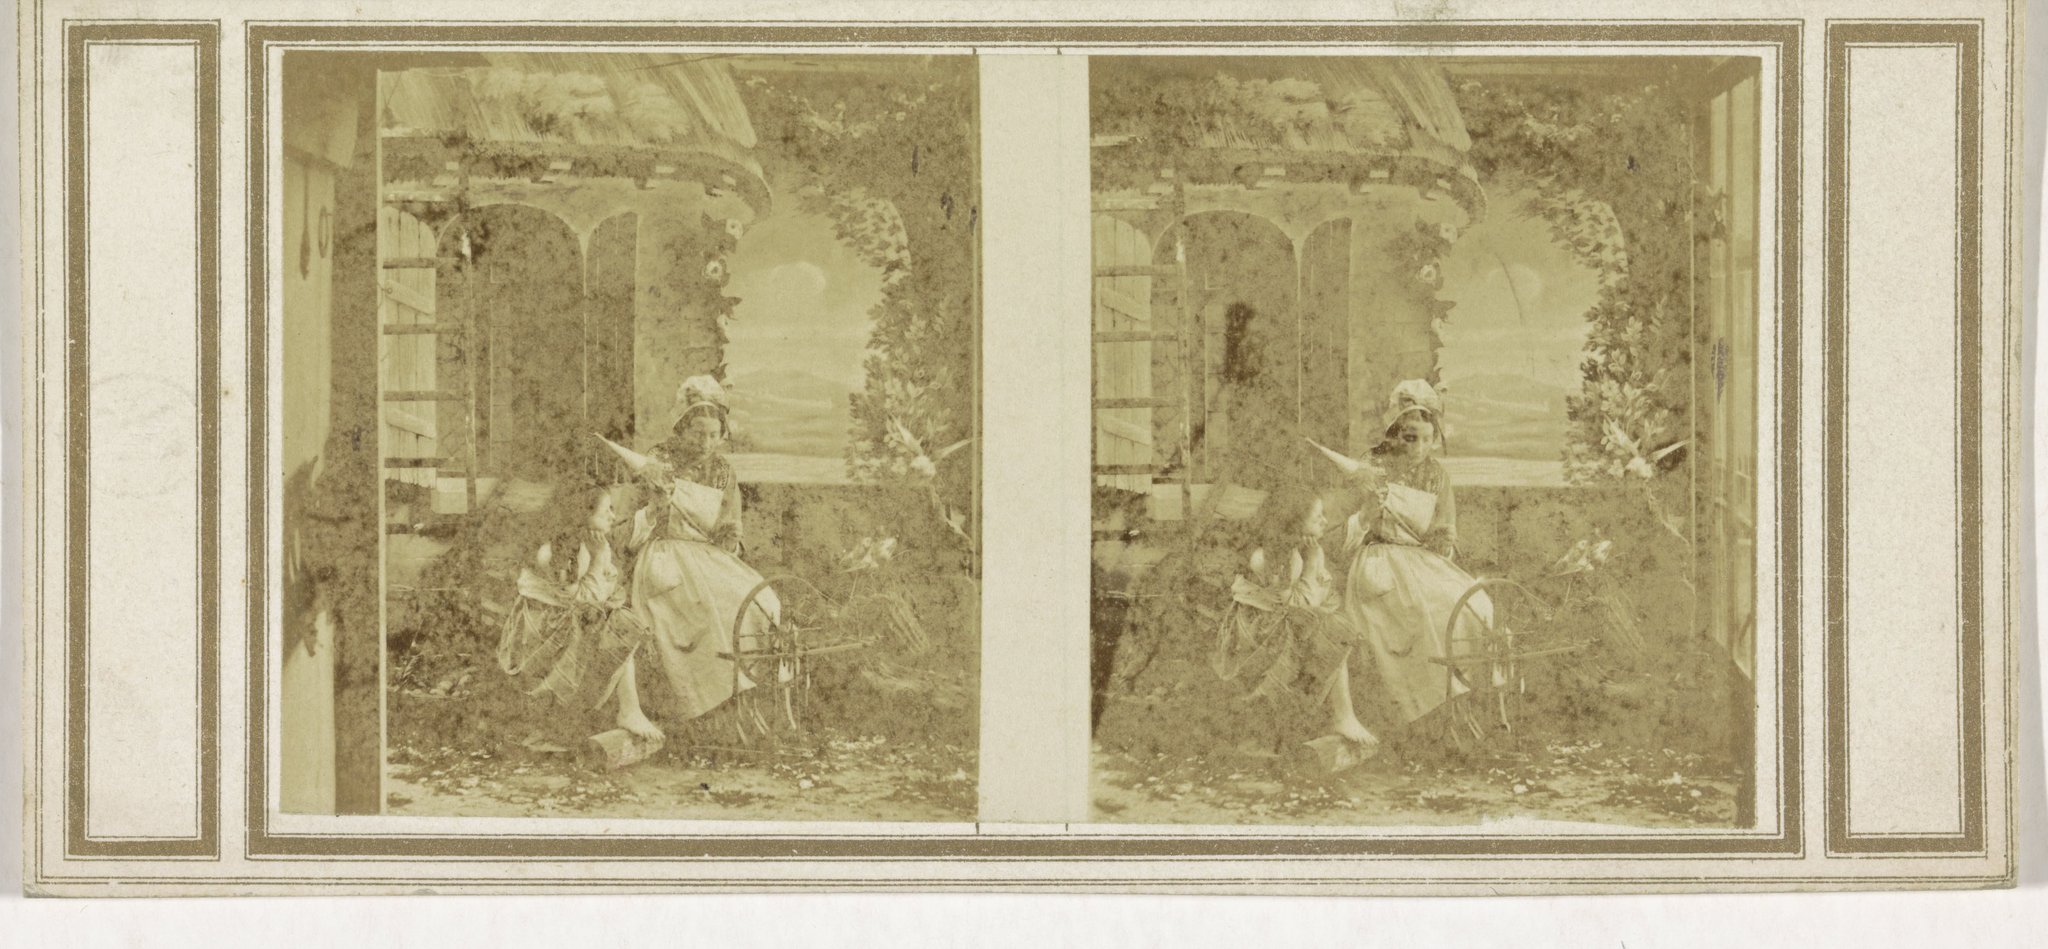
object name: stereograph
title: Vrouw en meisje achter spinnewiel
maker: pierre-ambroise richebourg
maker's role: fotograaf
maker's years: 1810-1875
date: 1850-1870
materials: photographic support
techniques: albumen print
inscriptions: check stamp: ‘monogram LM (?)’, number: ‘193’